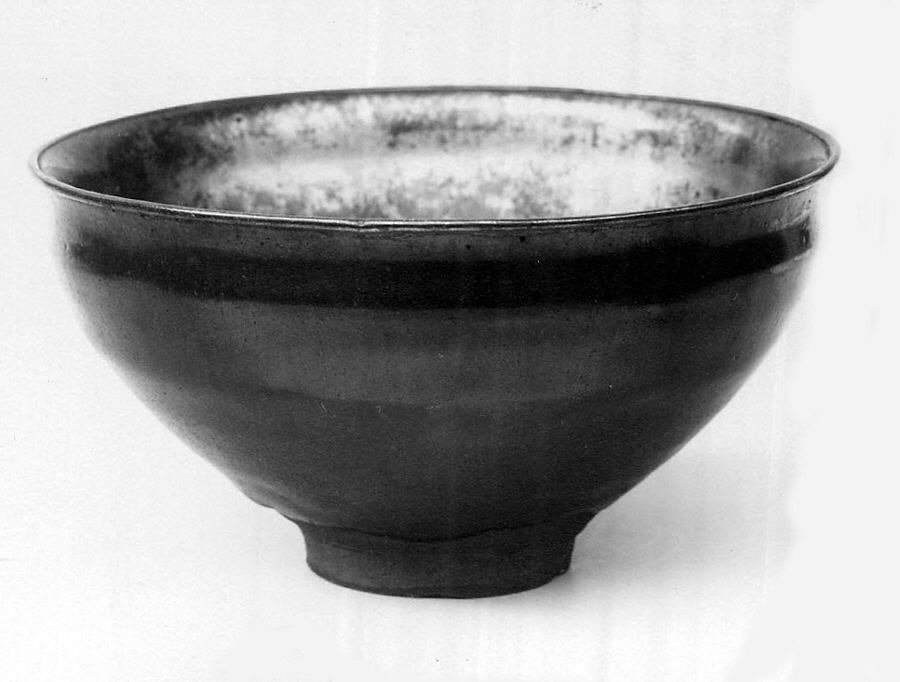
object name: teabowl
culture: japanese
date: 1820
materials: clay, glaze, silver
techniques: gilding